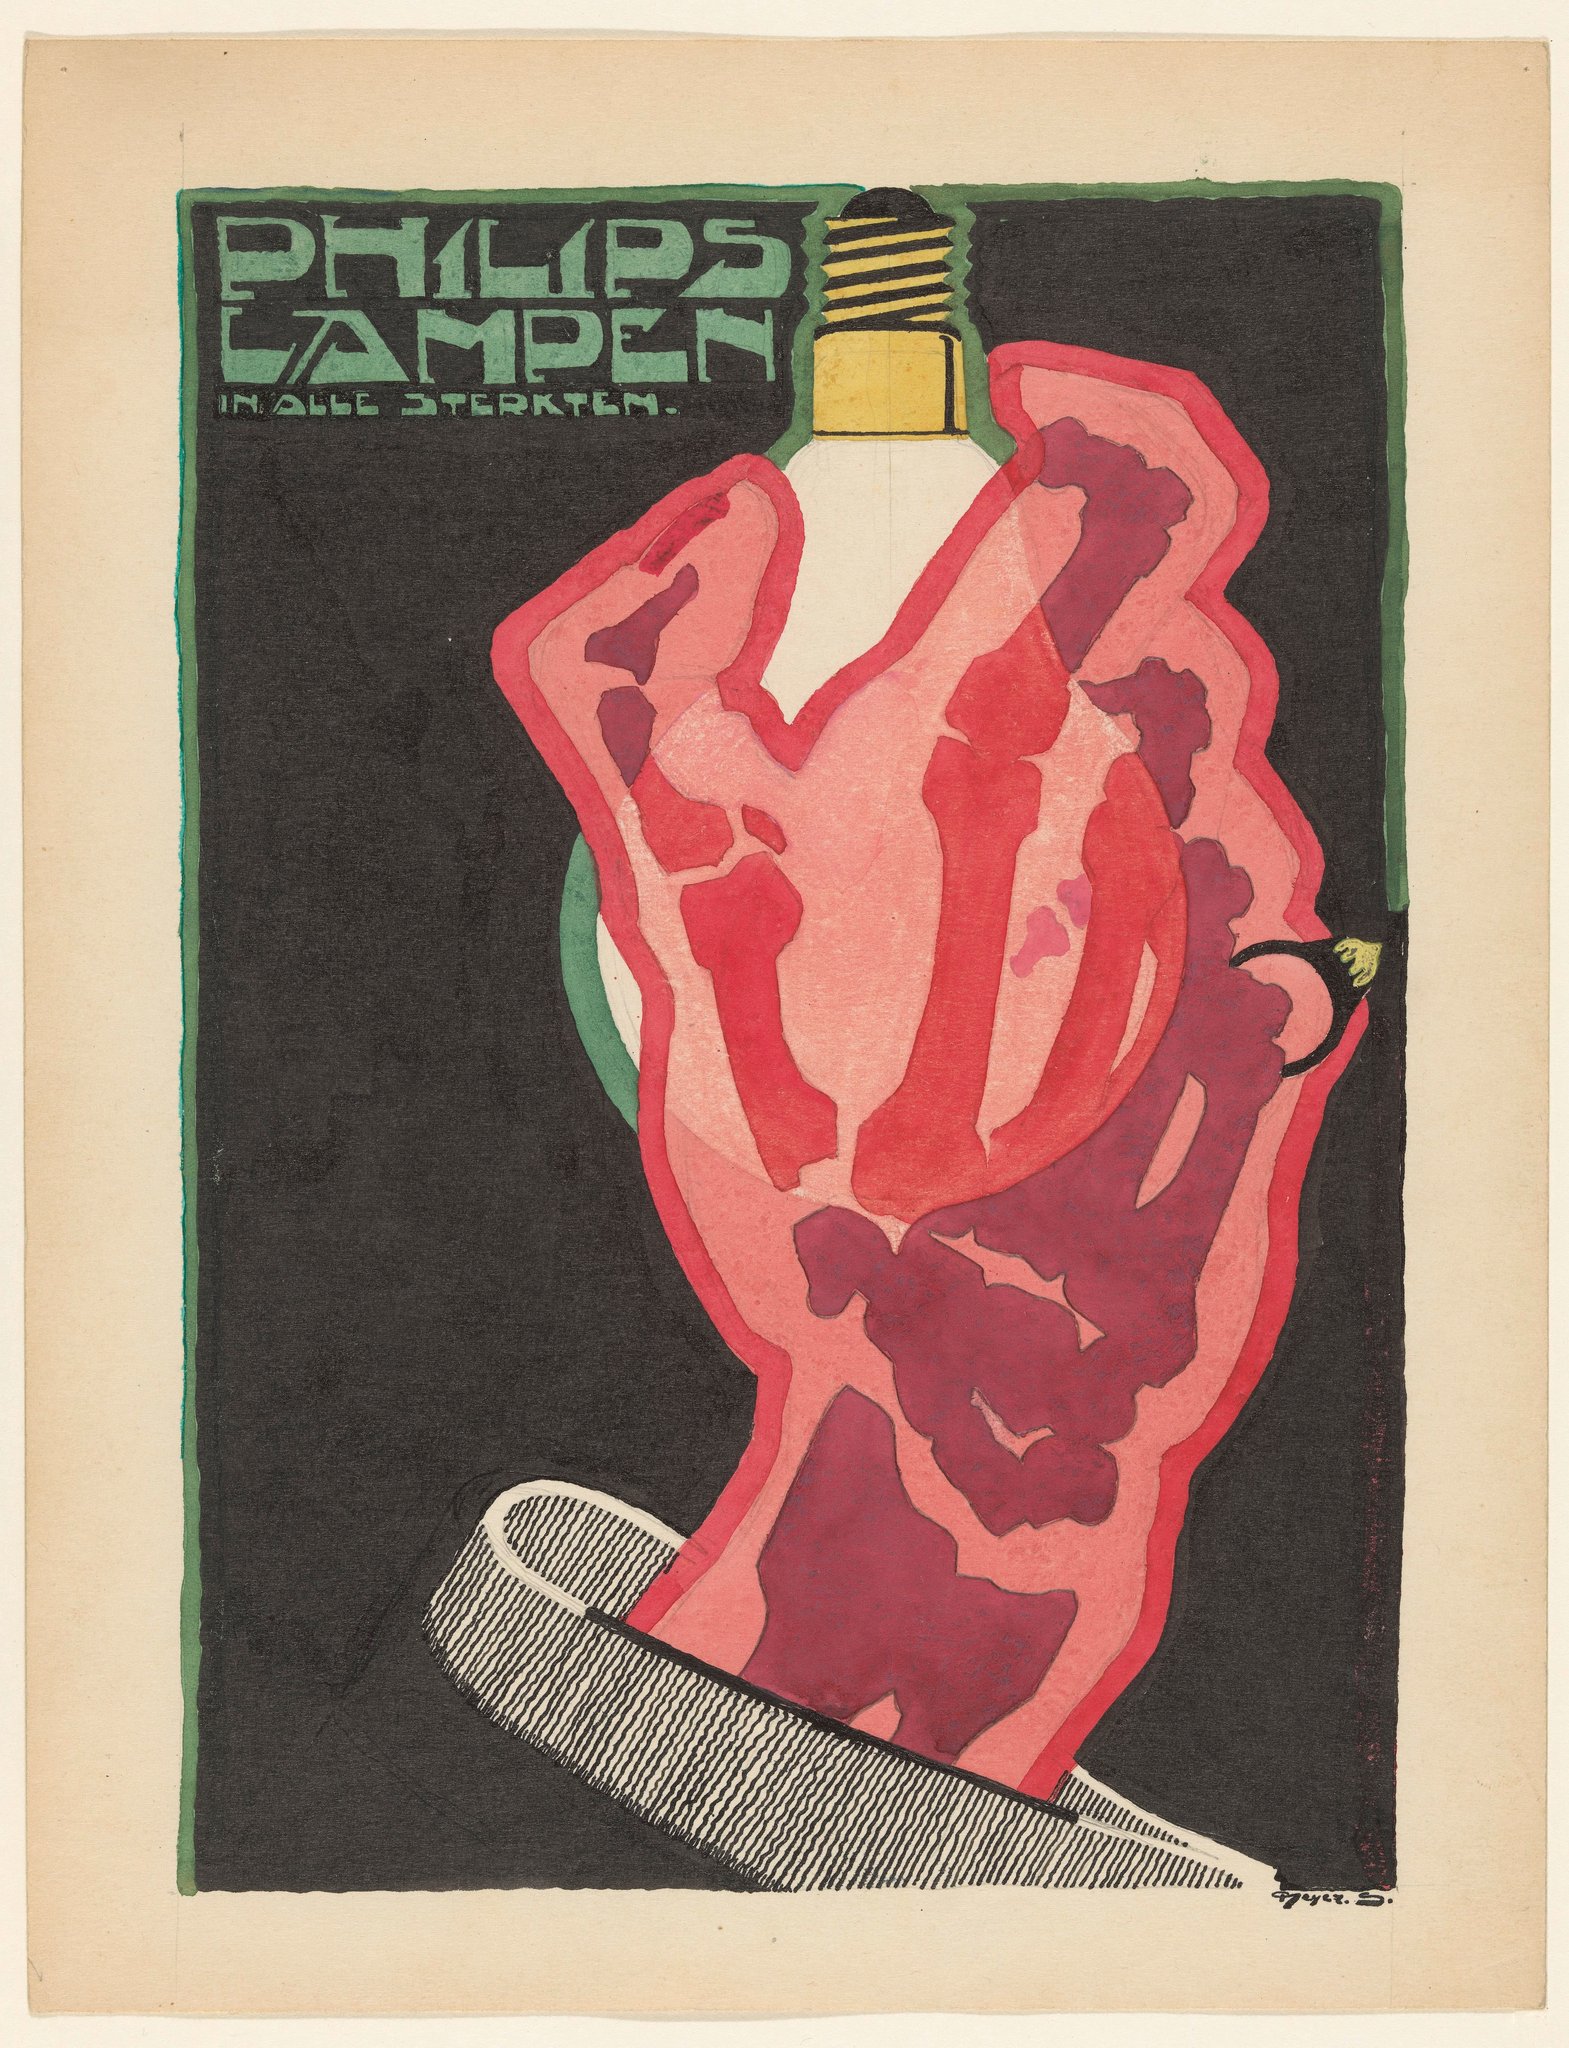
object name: drawing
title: Philips lampen in alle sterkten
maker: reijer stolk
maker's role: draughtsman, print maker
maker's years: 1896-1945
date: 1906-1945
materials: ink, paper, pencil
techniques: brush, pen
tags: (other) historical names, advertisement, notice, electric lamp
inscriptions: collector's mark: Lugt 2228, collector's mark: Lugt 2760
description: Deze tekening is mogelijk een ontwerp voor een affiche.